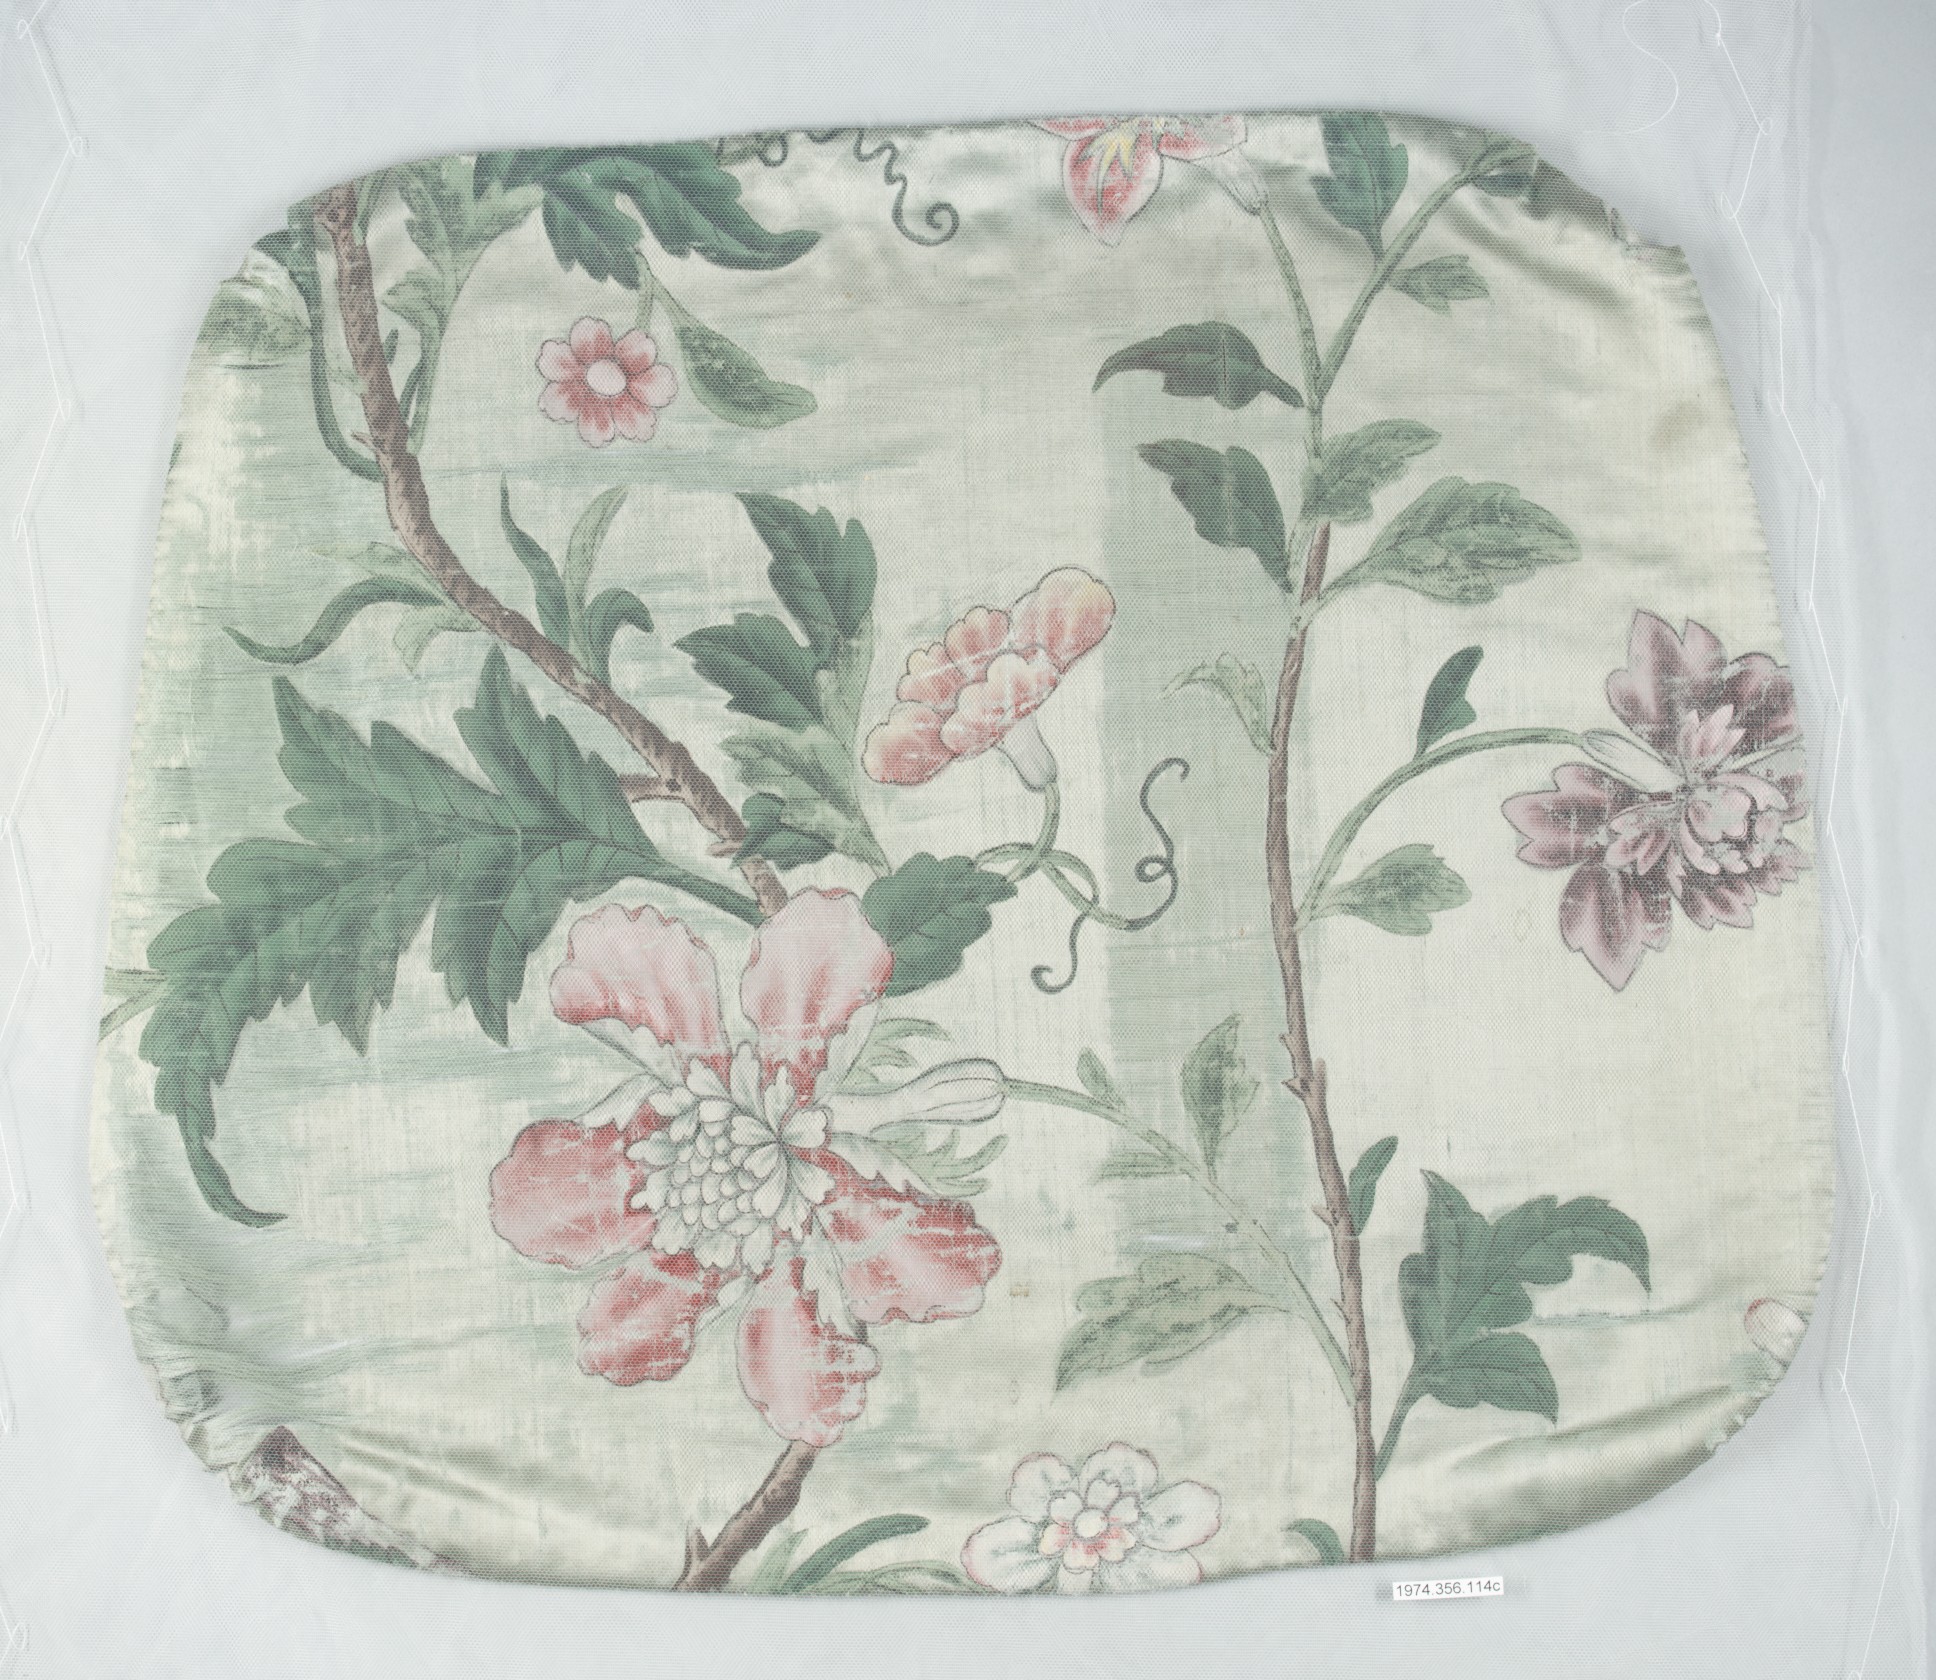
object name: upholstery panel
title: Upholstery panels for a side chair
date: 1763-1764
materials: silk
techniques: painting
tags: flowers